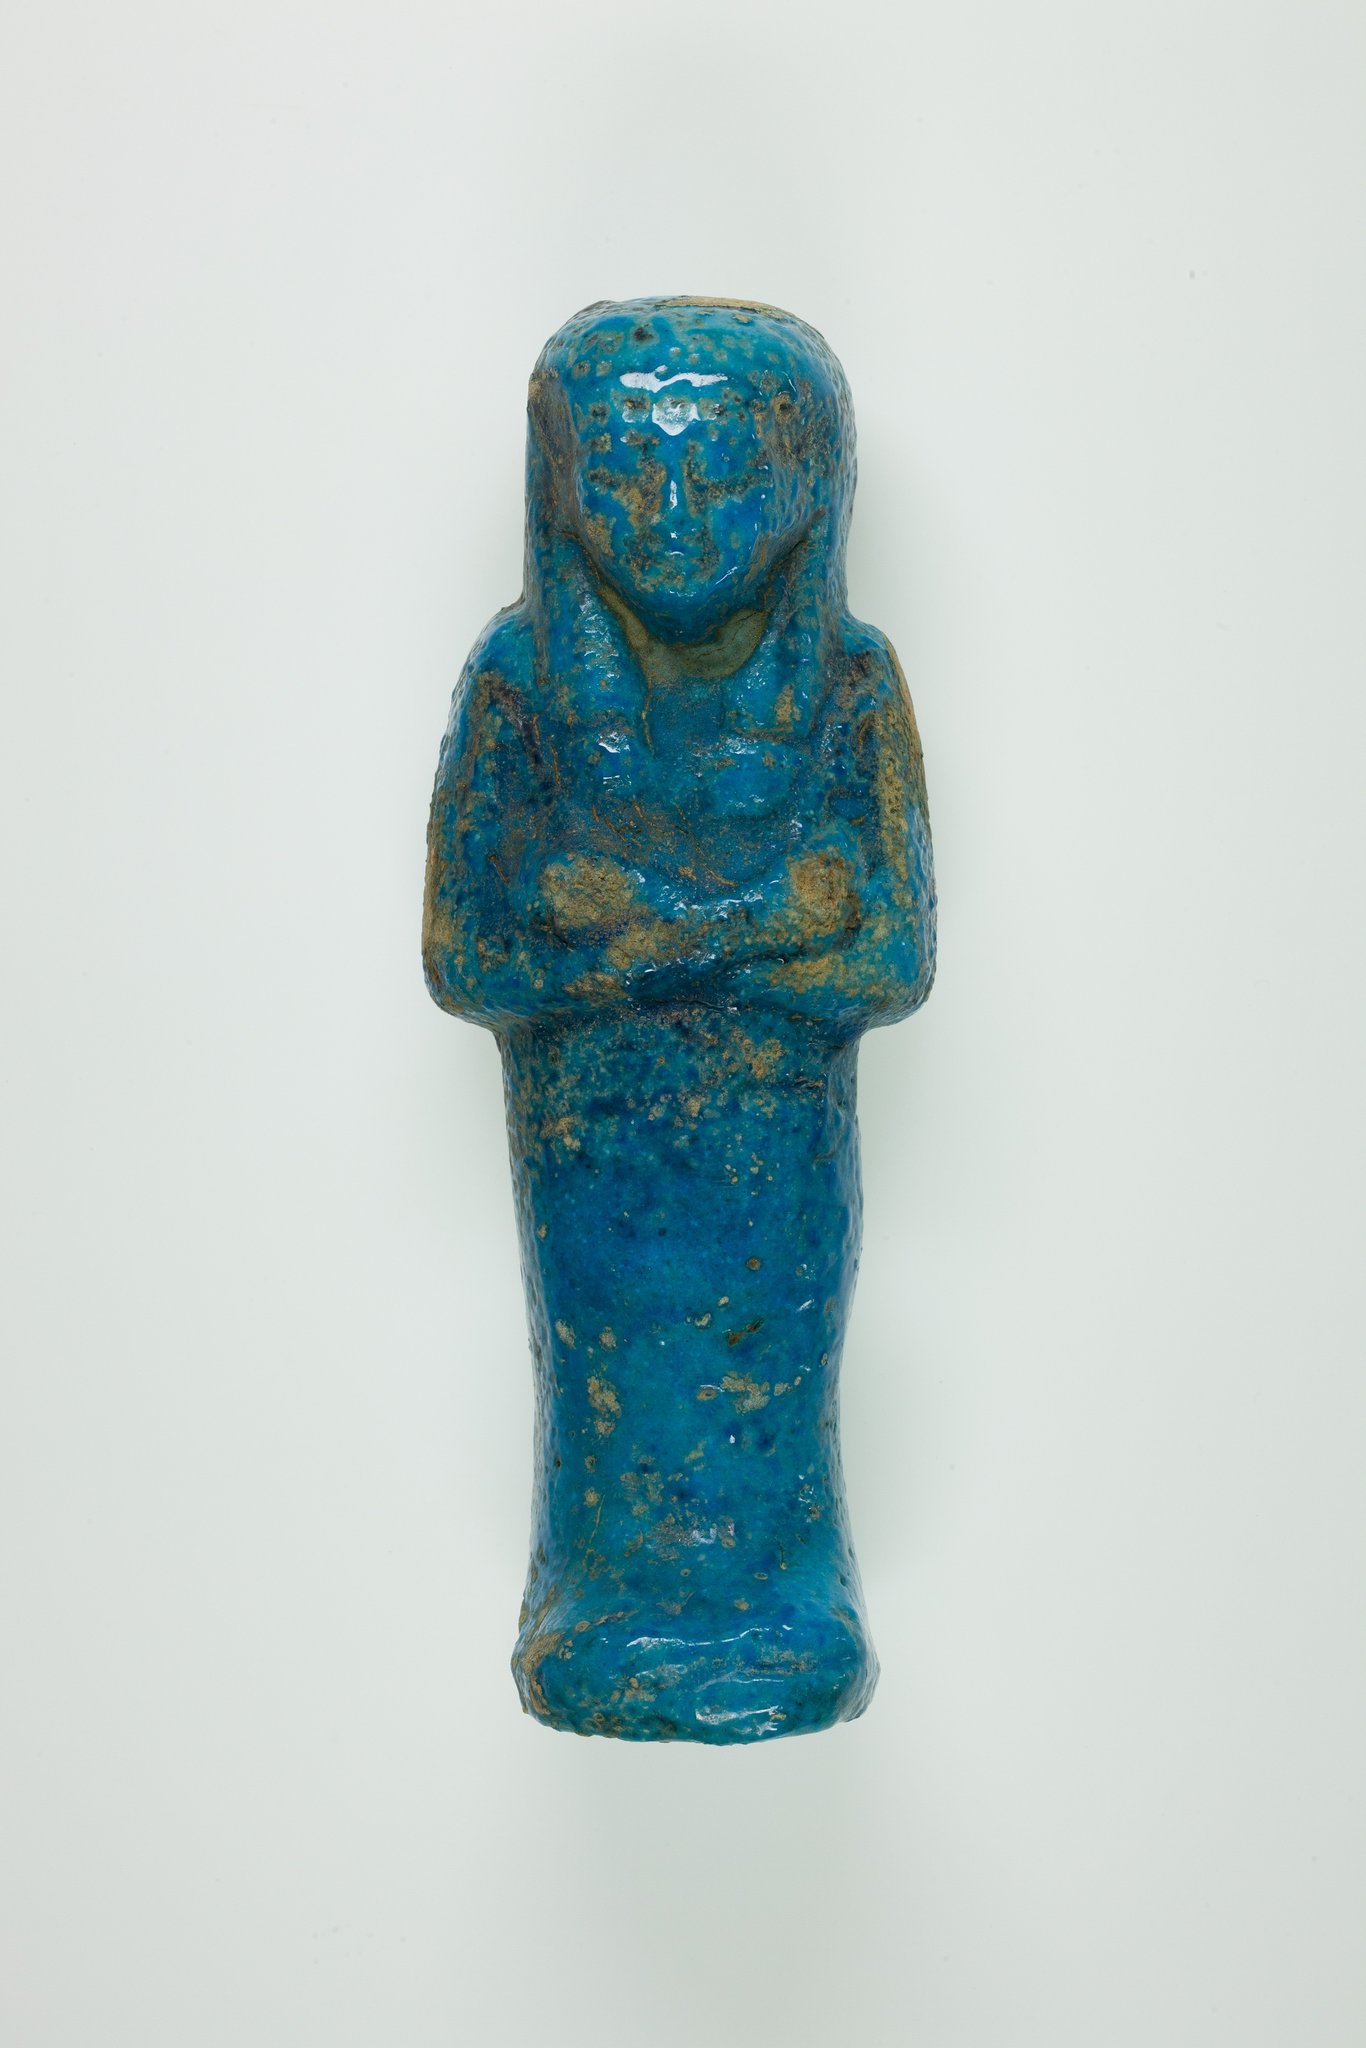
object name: worker shabti, henettawy c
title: Worker Shabti of Henettawy (C), Daughter of Isetemkheb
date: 990-970 BCE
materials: faience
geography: egypt